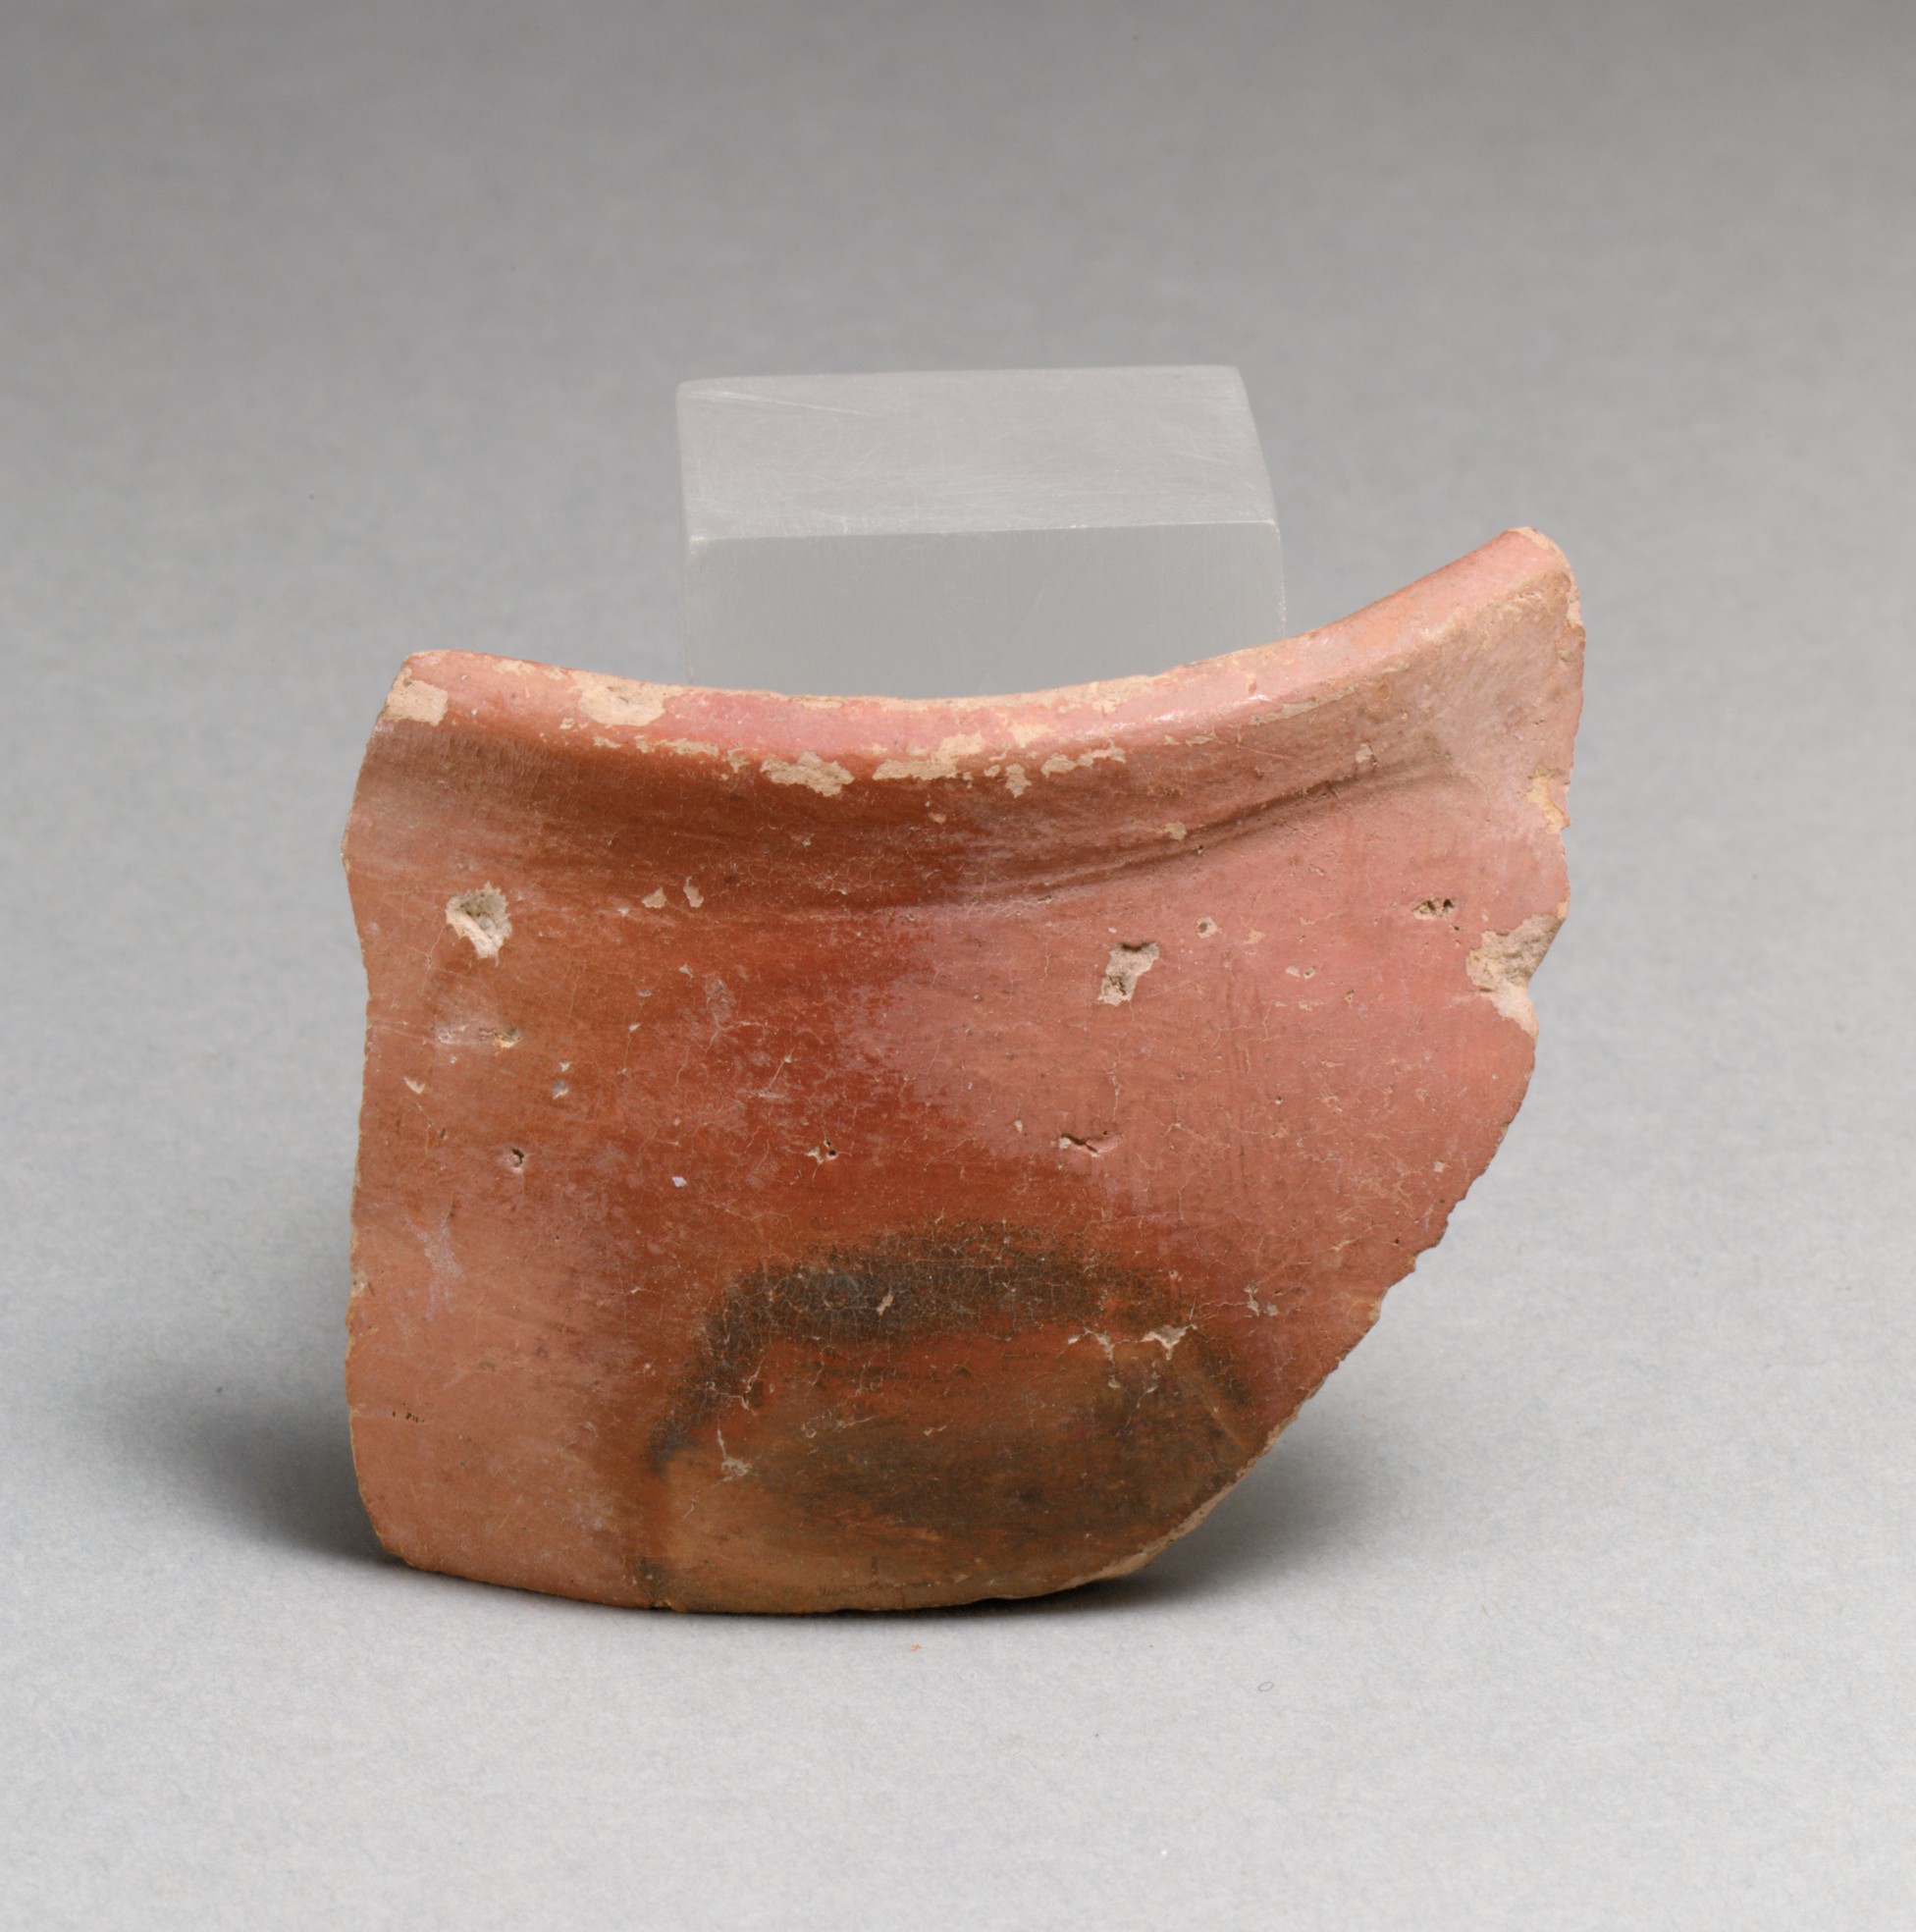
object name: vase fragment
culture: minoan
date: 2600-2000 BCE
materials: terracotta